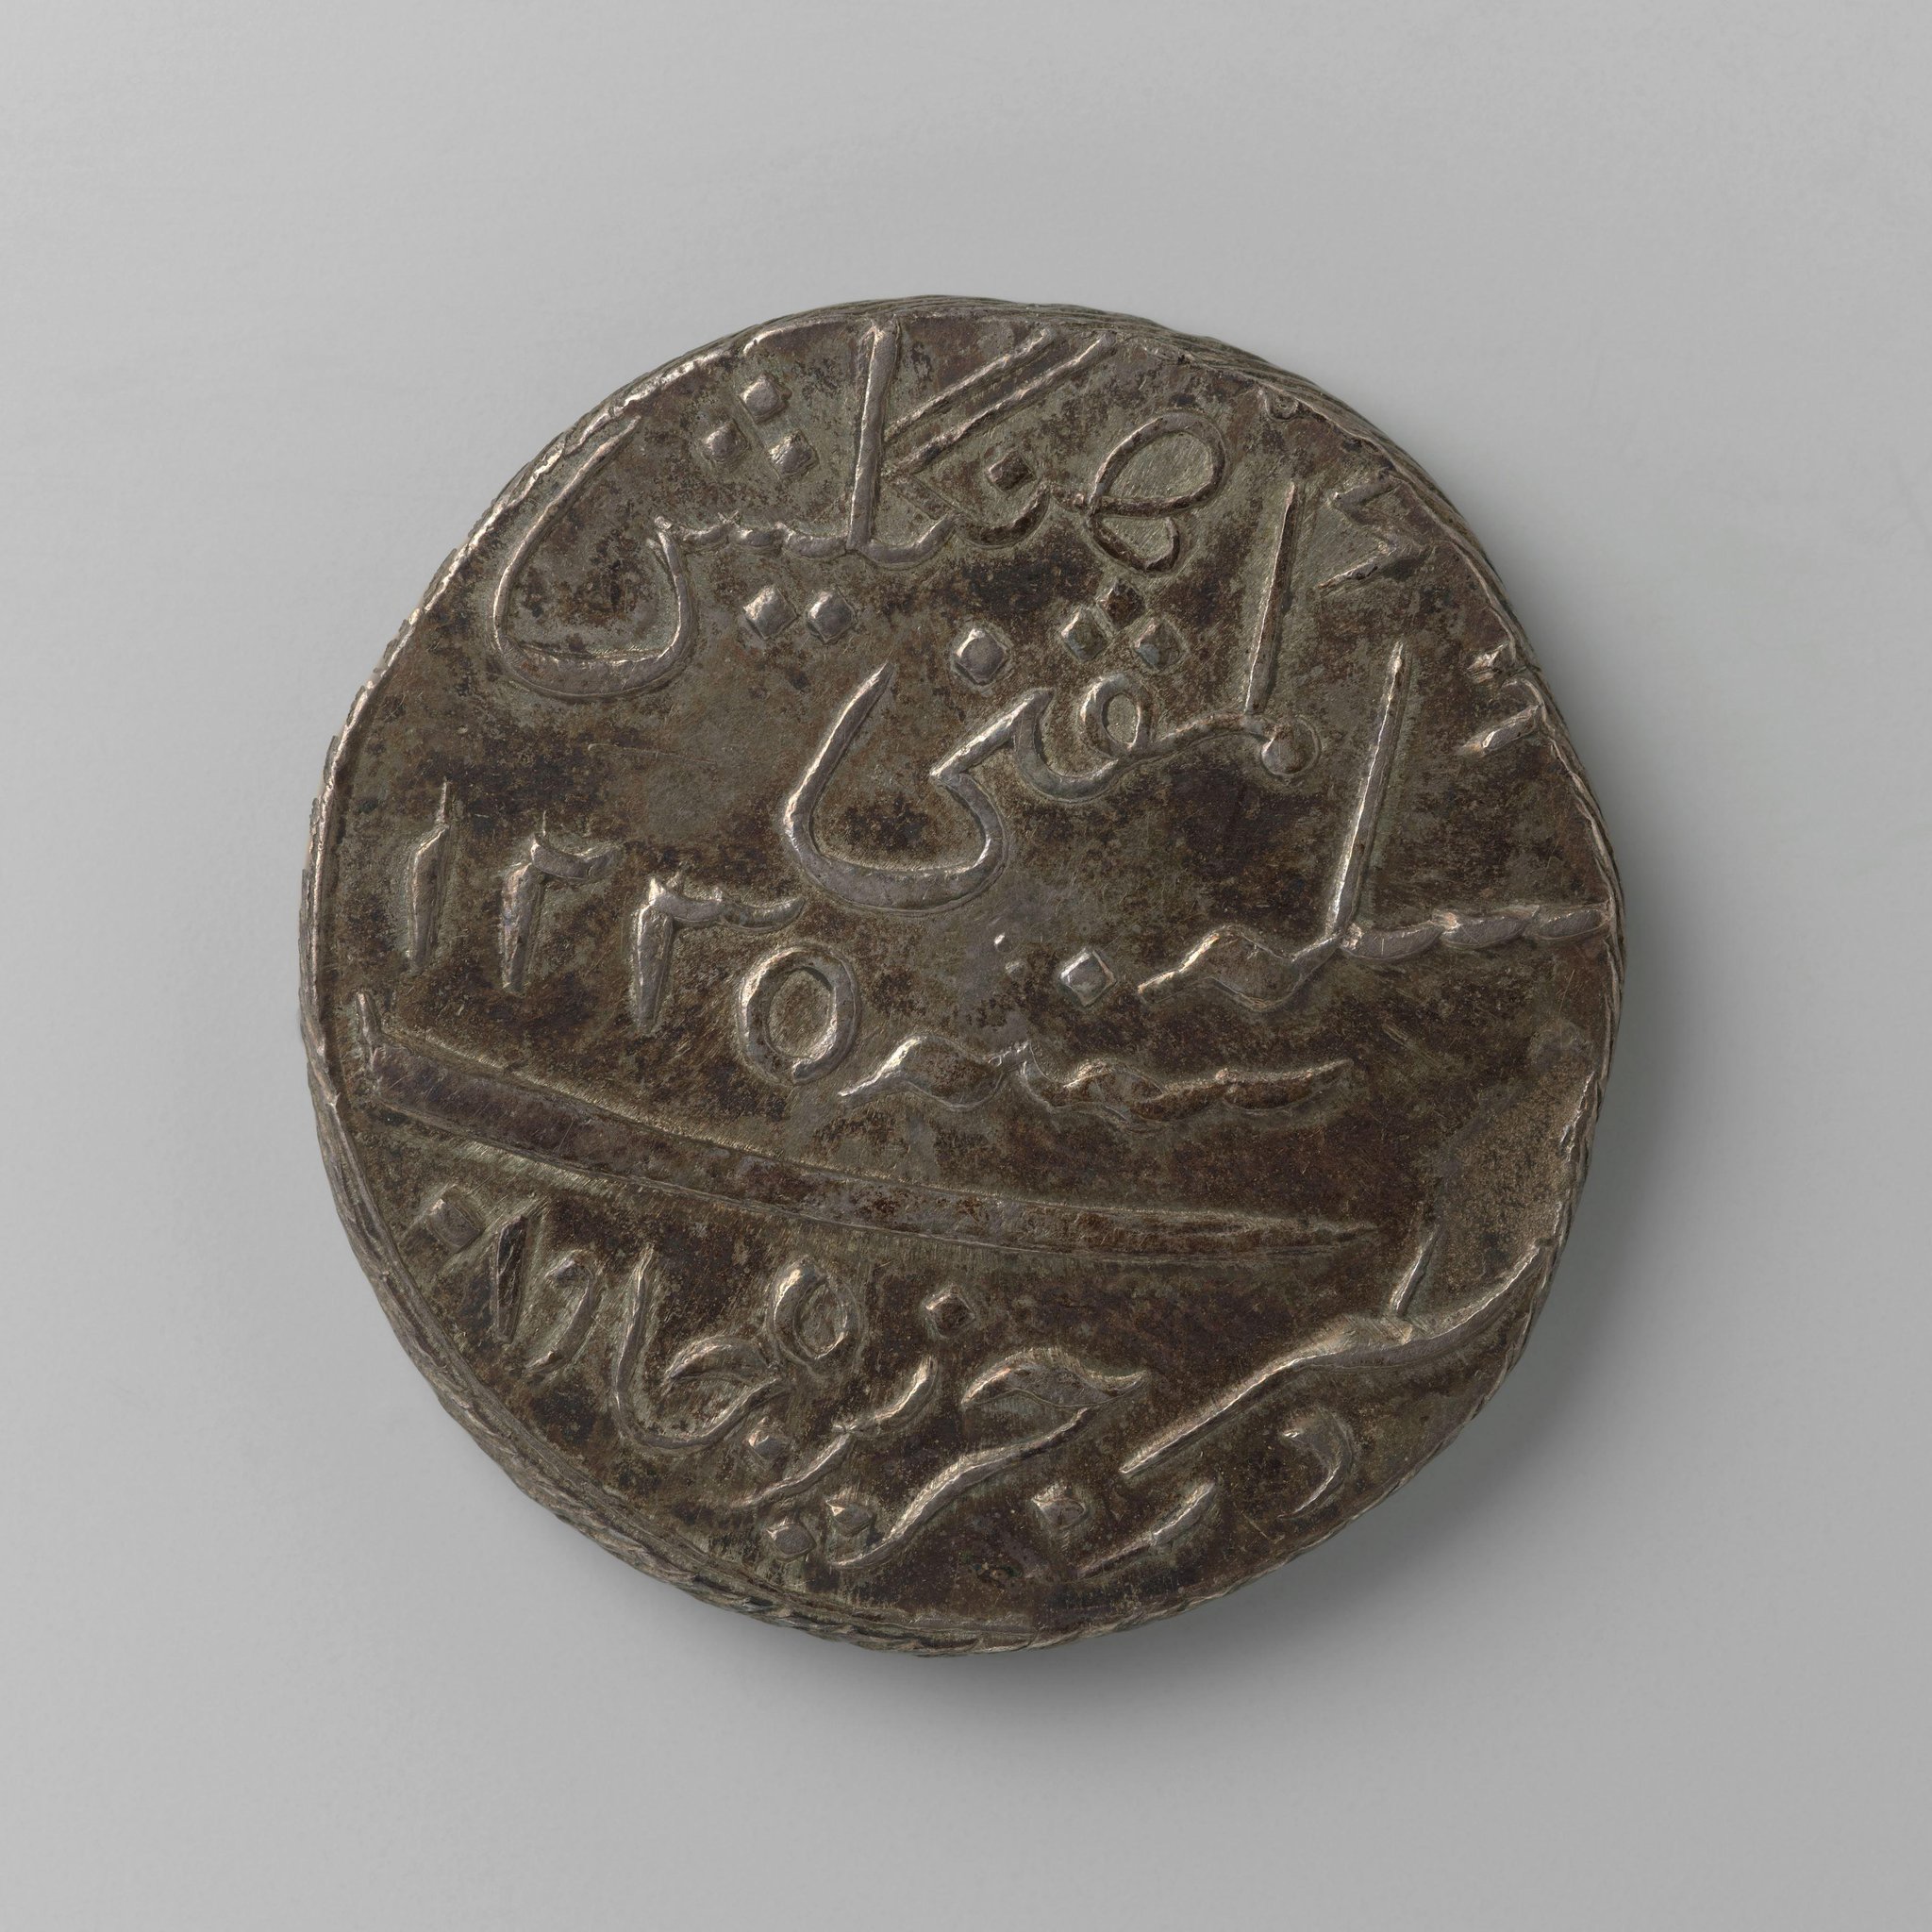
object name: coin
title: Nederlands Indië tijdens Brits bestuur, zilveren ropij, 1815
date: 1815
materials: silver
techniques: striking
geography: surabaya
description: Zilveren munt. Voorzijde: drieregelig opschrift in het Javaans met op onderste regel jaartal. Daarboven muntteken en daaronder muntmeesterteken Z [=muntmeester Zwekkert]. Keerzijde: vijfregelig opschrift in het Arabisch, waariin jaartal in Islamitische jaartelling. Kabelrand.